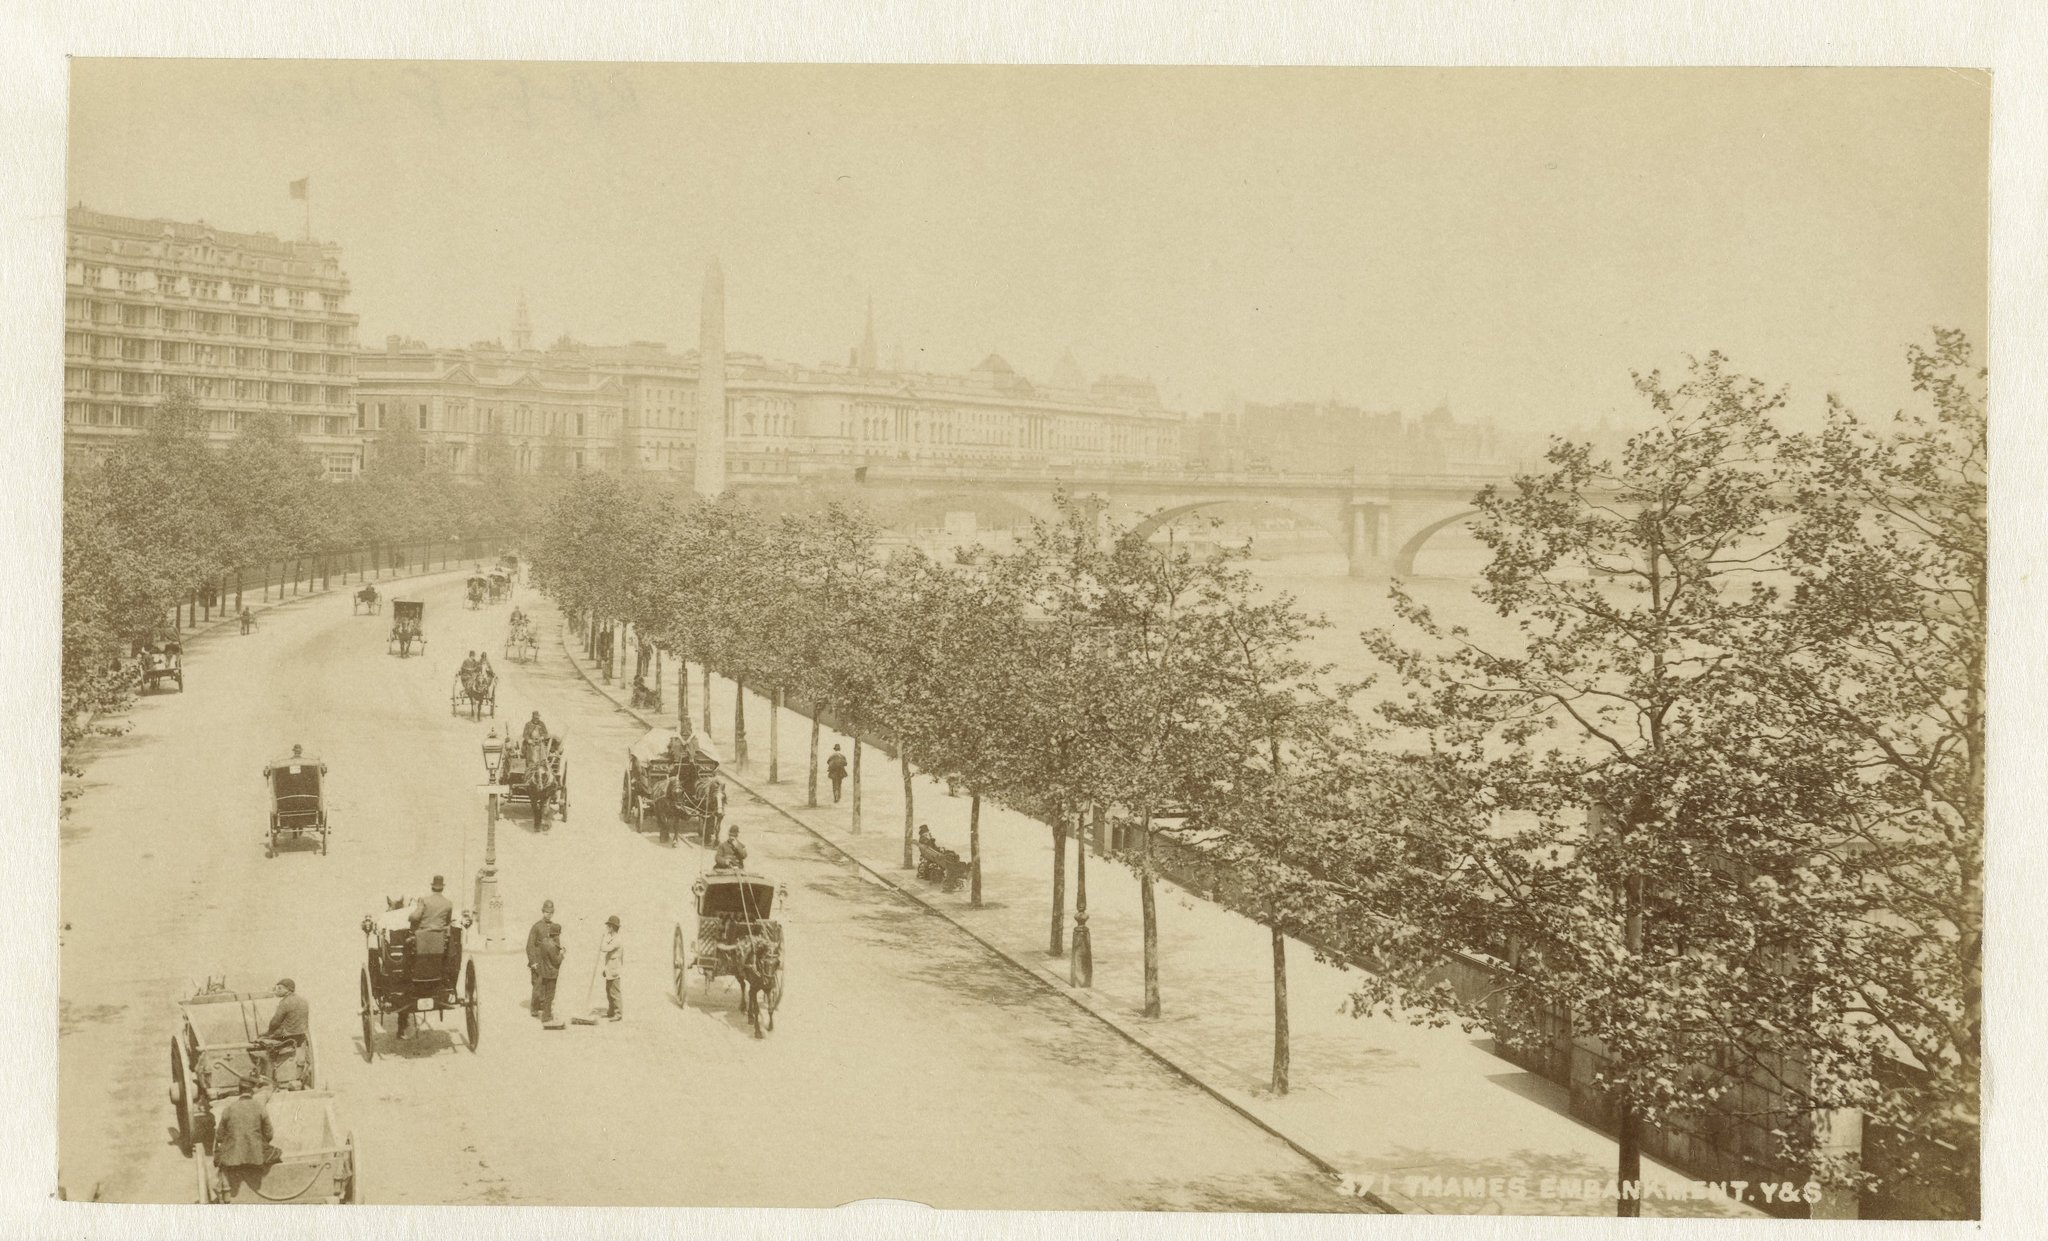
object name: photograph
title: Victoria Embankment met zicht op Waterloo Bridge, Londen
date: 1851-1890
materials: paper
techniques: albumen print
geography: london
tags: bridge in city across river, canal, etc.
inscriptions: number: ‘371’